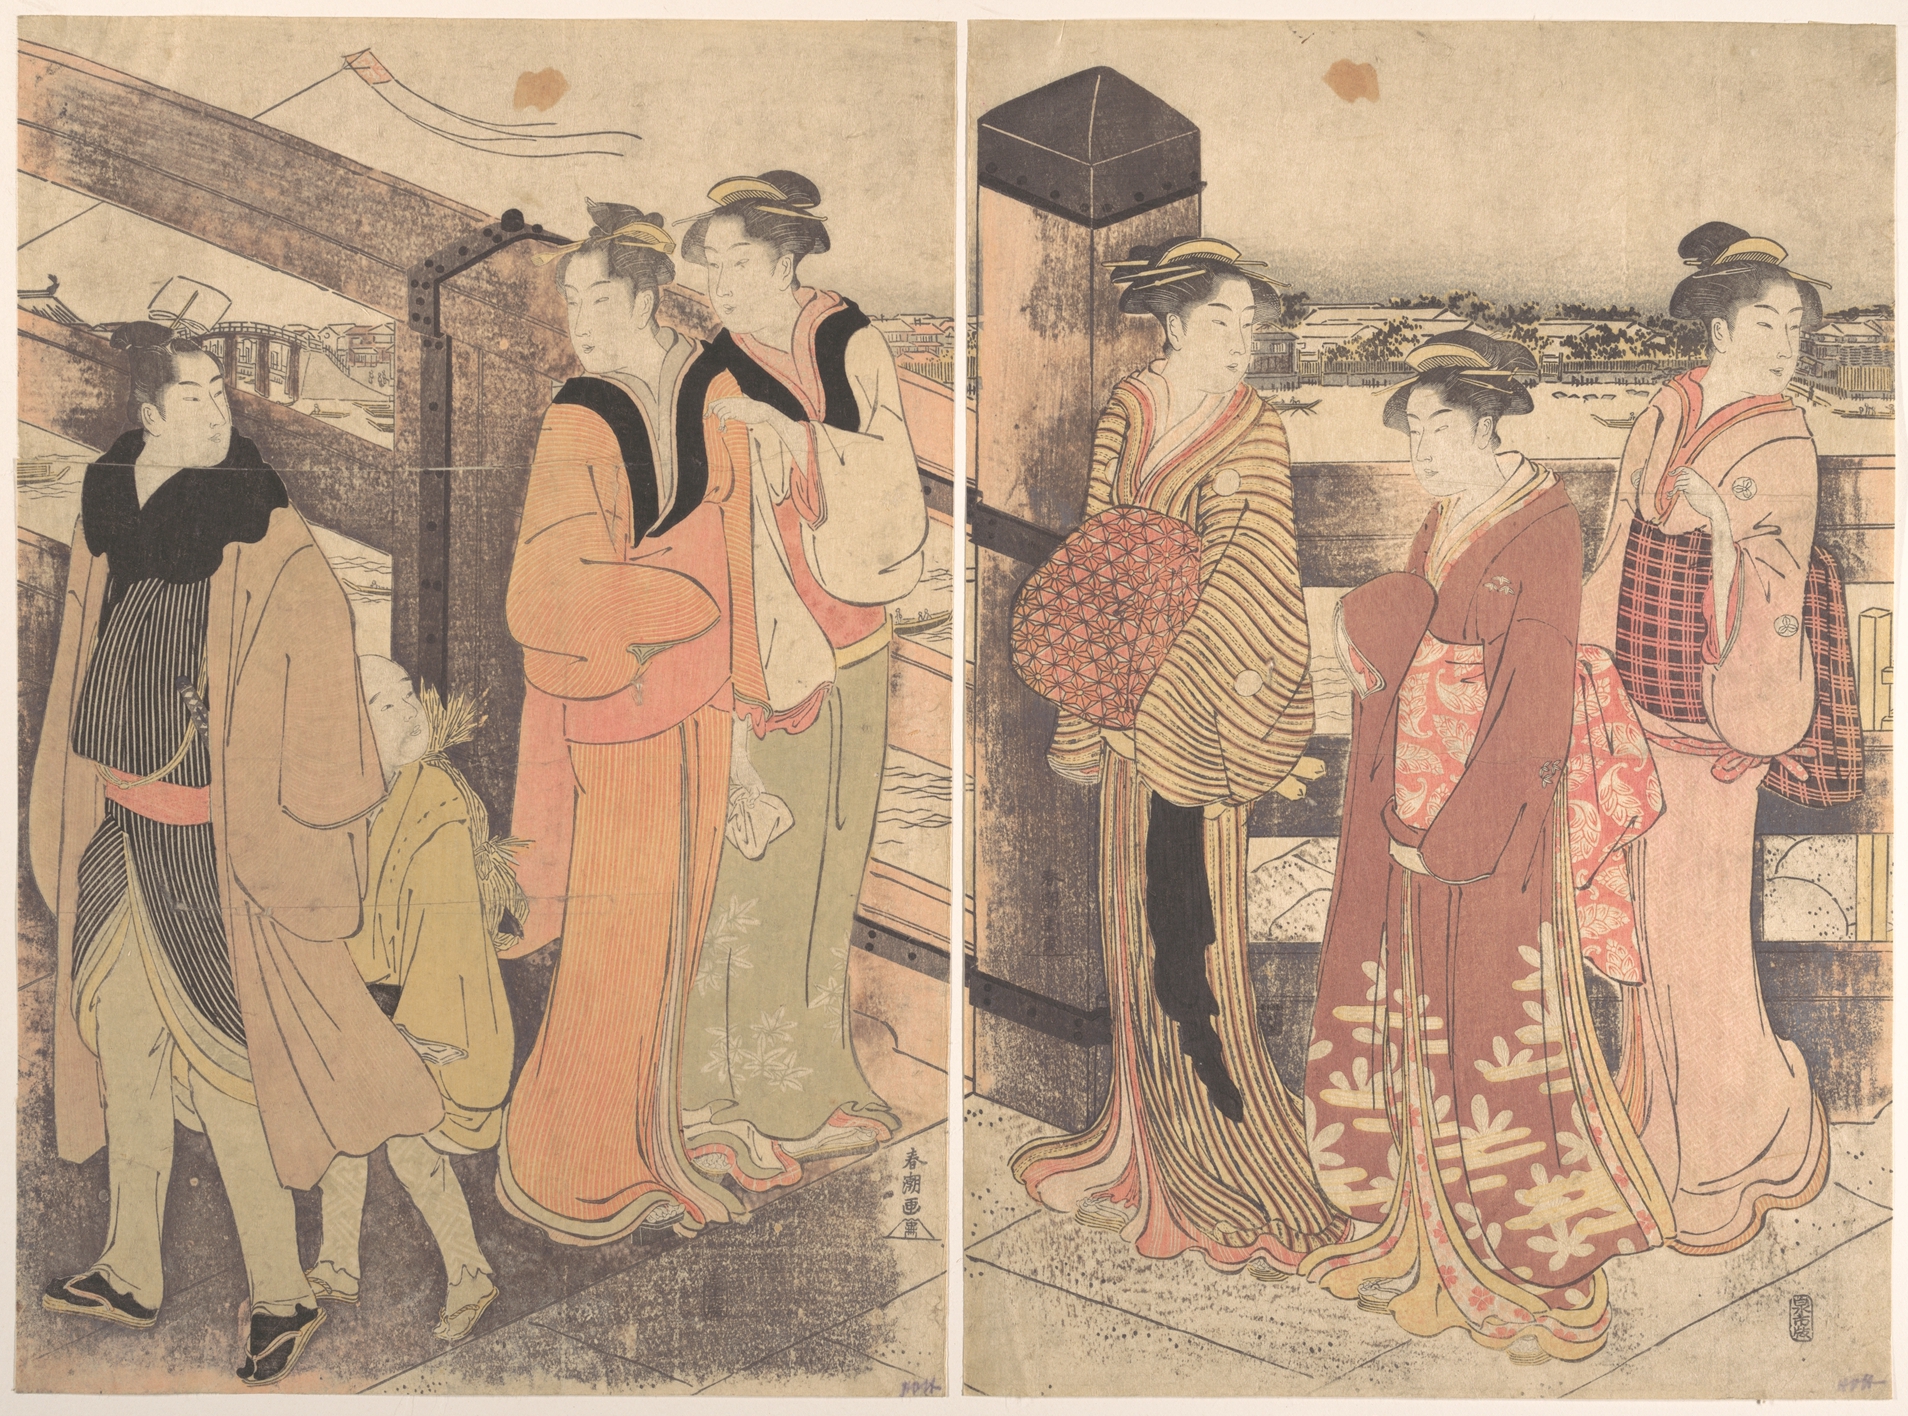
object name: woodblock print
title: A Group of Women, One Man and a Boy on a Bridge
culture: japanese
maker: katsukawa shunchō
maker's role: artist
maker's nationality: japanese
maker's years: 1775-1795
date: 1780-1795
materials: ink, paper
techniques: woodblock print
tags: bridges,boys,men,women